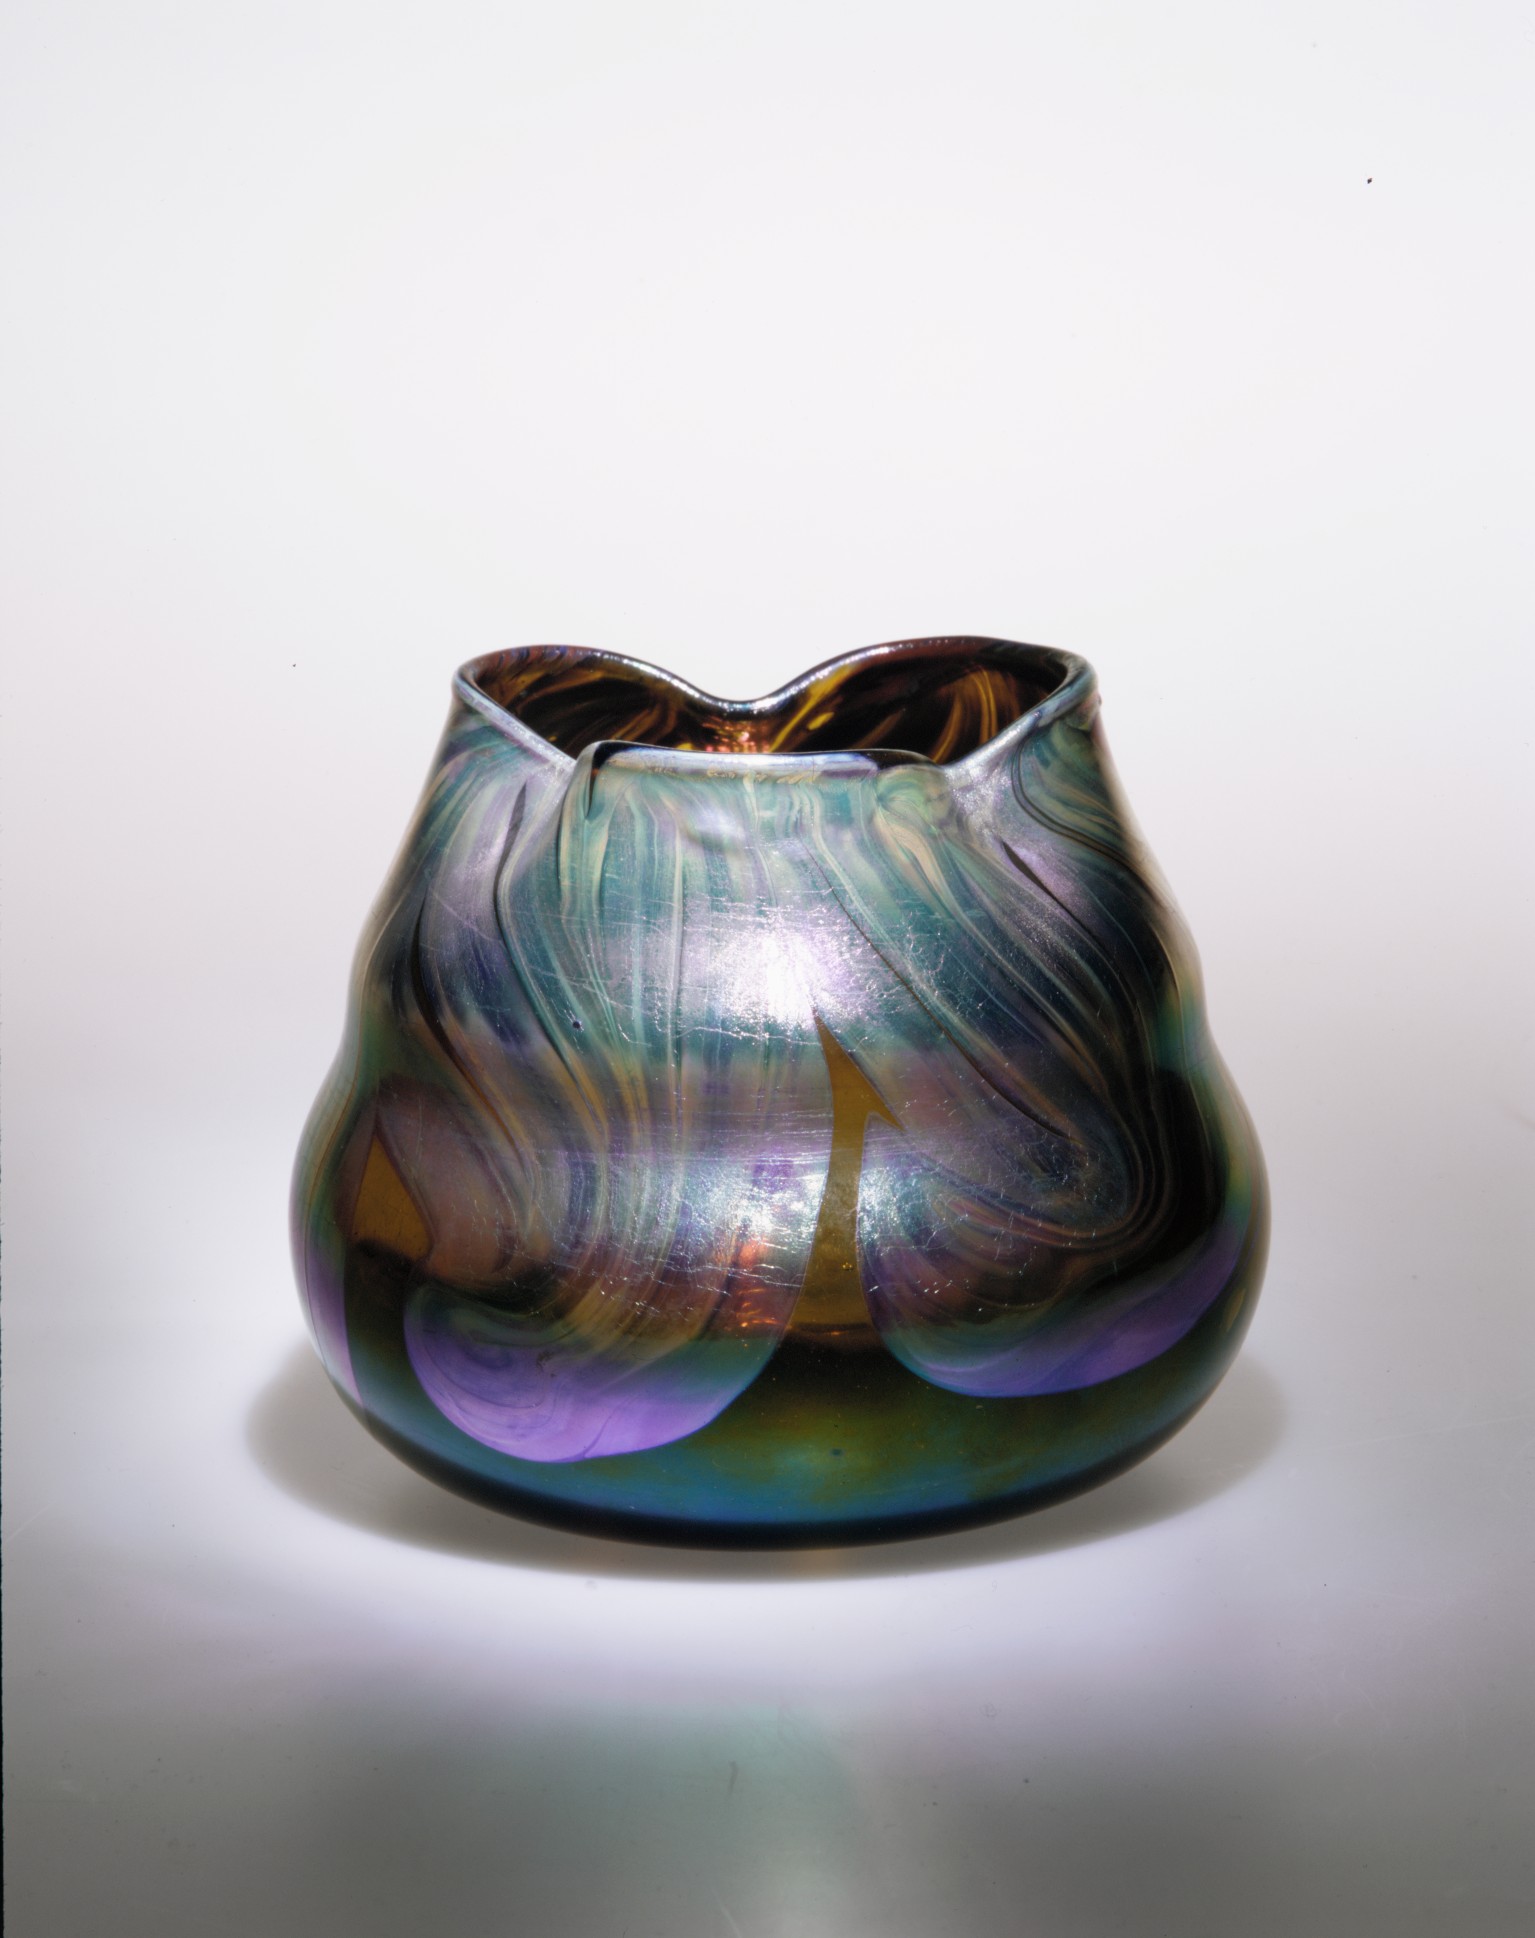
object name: bowl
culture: american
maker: louis c. tiffany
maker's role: designer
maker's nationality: american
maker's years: 1848-1933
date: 1893-1896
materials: glass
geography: united states